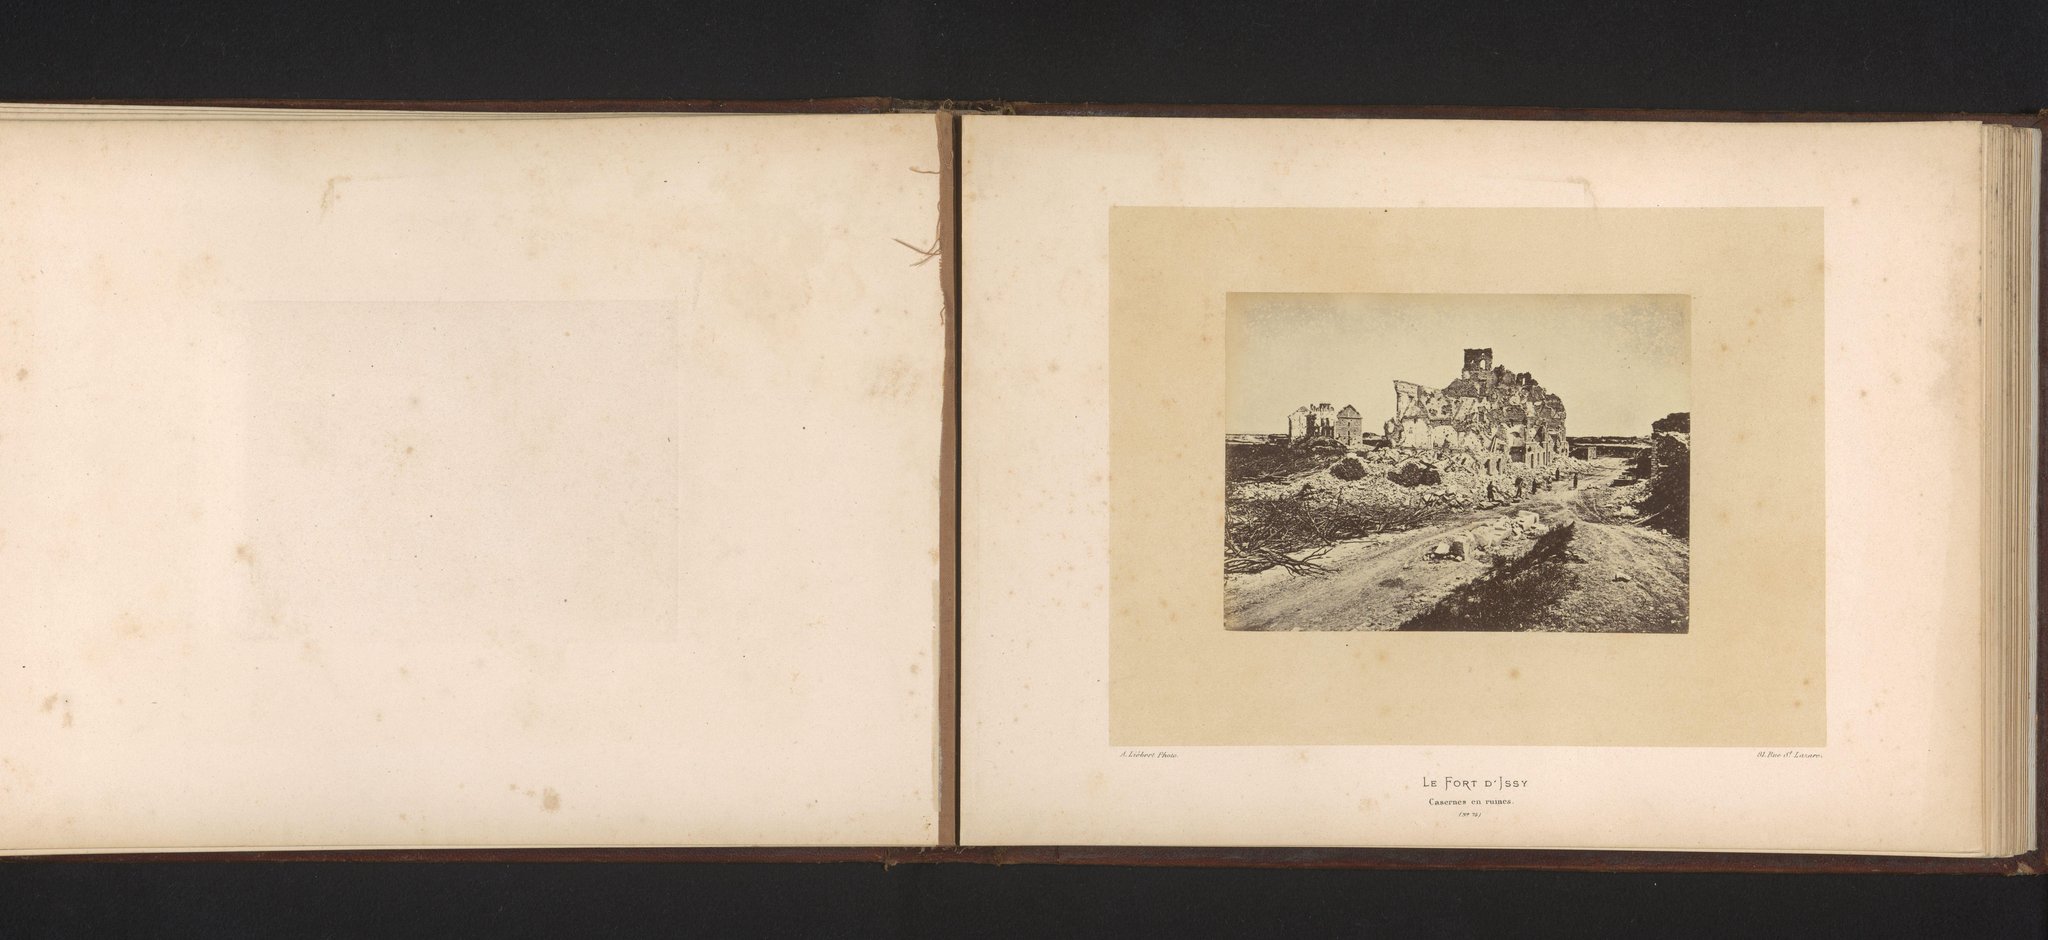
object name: page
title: Gezicht op de resten van een barak van Fort d'Issy in Issy-les-Moulineaux na de verwoesting door de Commune van Parijs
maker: alphonse-justin liébert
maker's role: fotograaf, marinier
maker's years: 1827-1914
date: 1871-1872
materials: photographic support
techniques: albumen print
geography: issy-les-moulineaux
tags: fortress, ruin of a building ~ architecture, barracks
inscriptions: number: ‘(No. 75)’, address: ‘31, Rue St. Lazare’